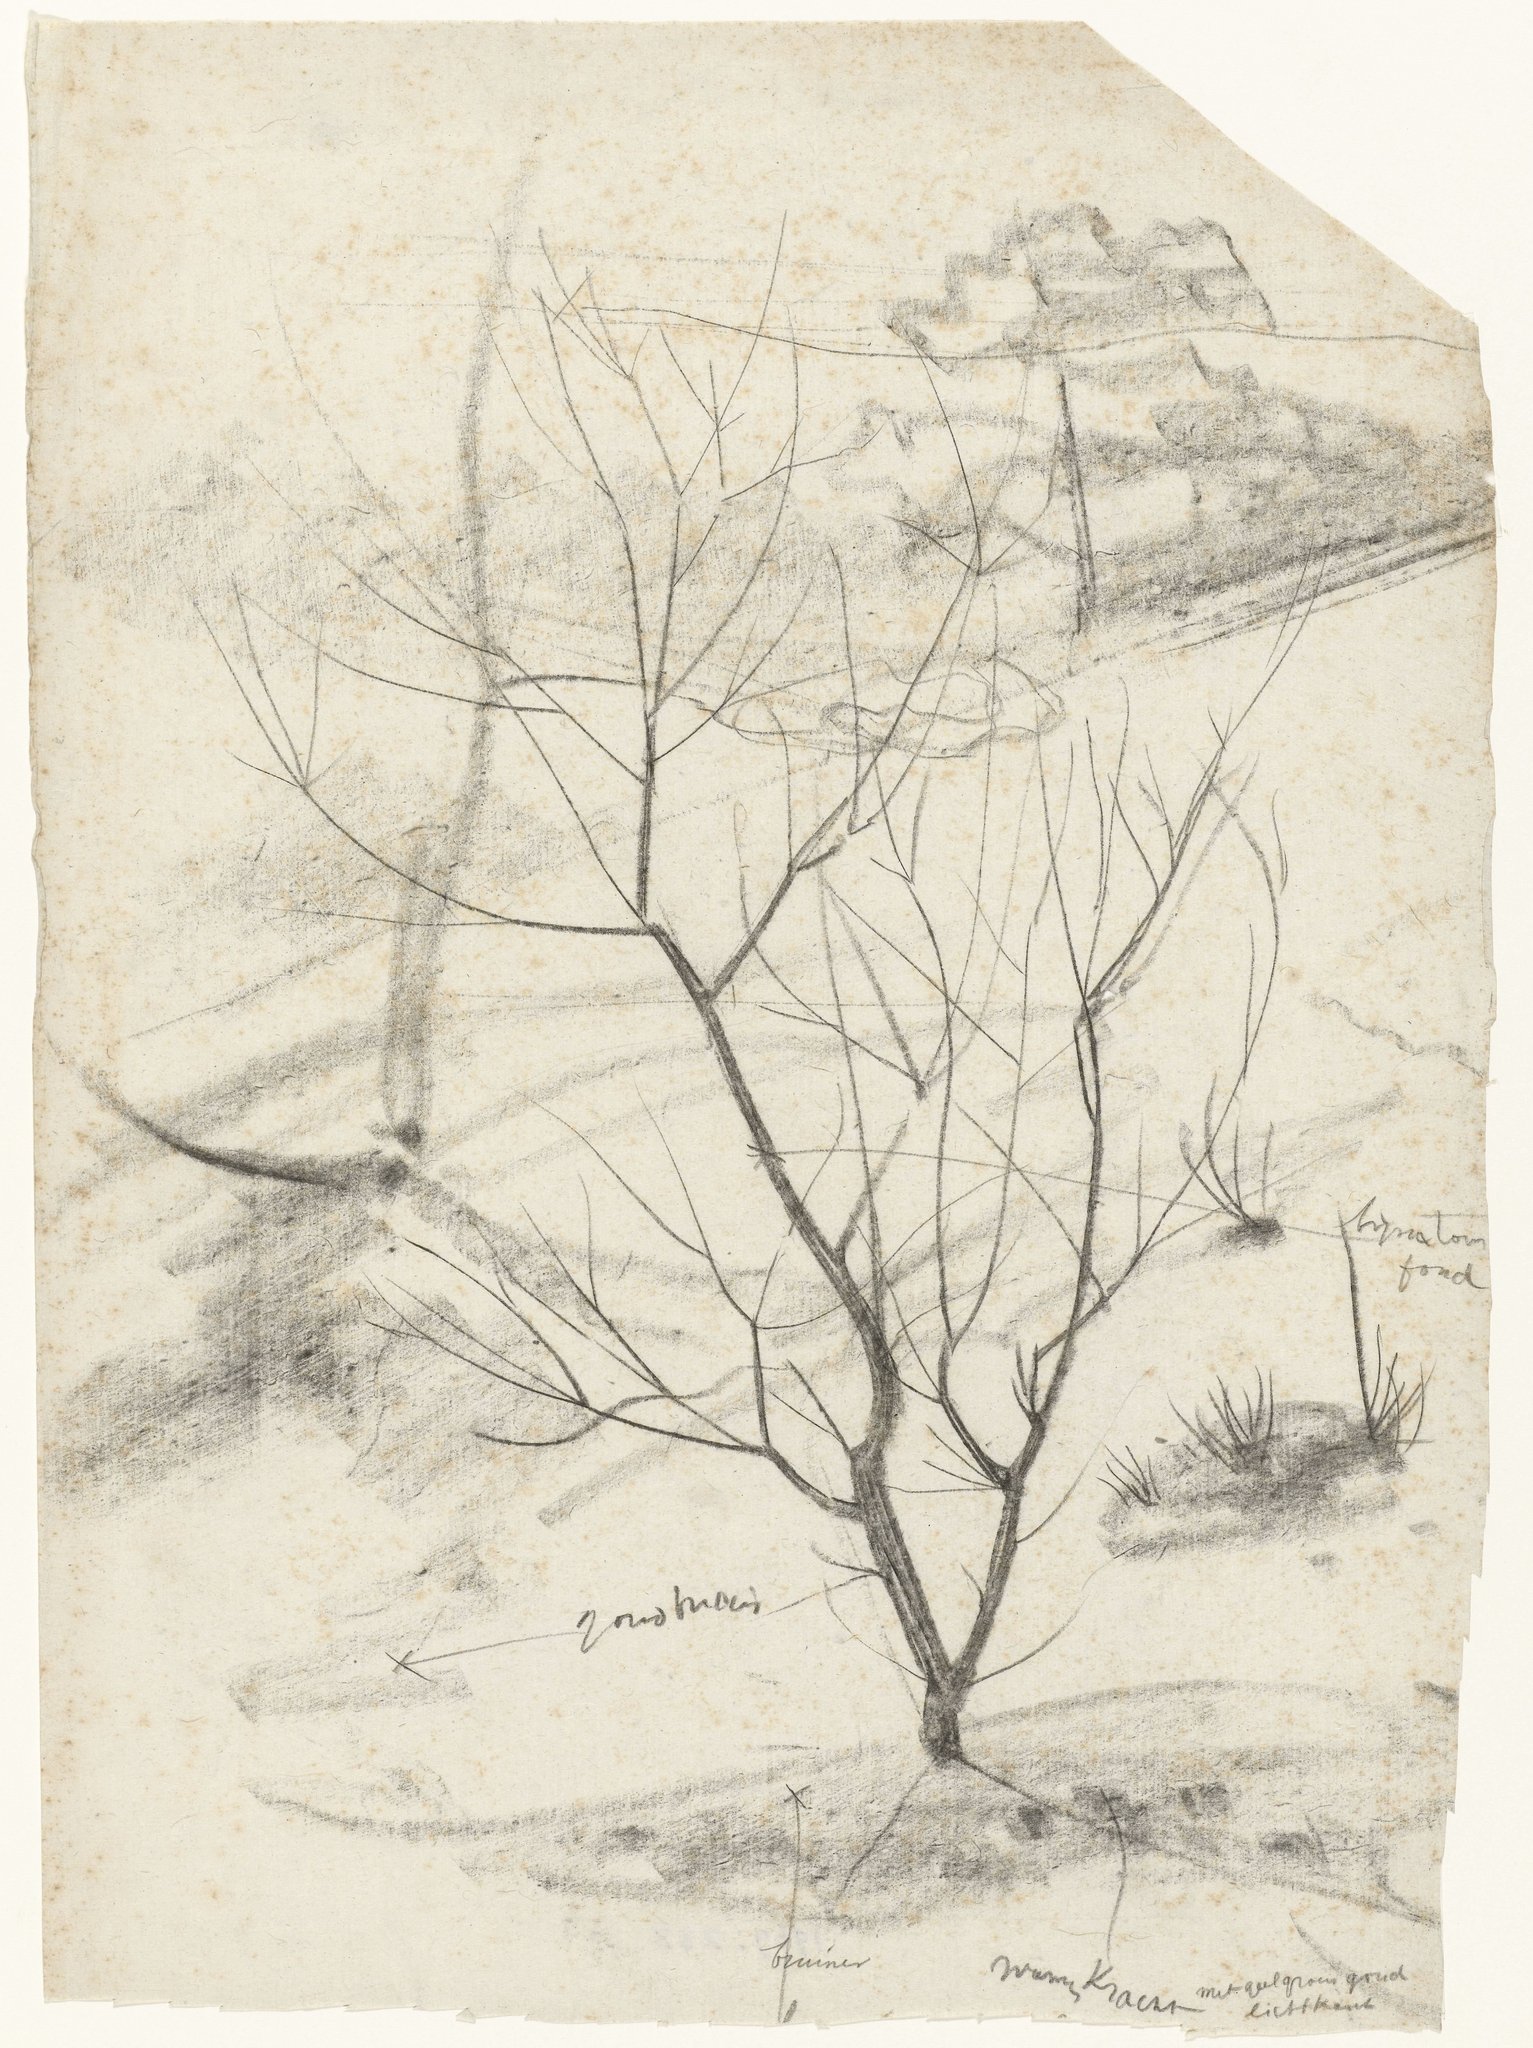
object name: drawing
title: Kale boom op een helling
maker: gerrit willem dijsselhof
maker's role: designer, draughtsman, print maker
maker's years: 1866-1924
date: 1876-1924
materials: chalk, paper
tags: trees